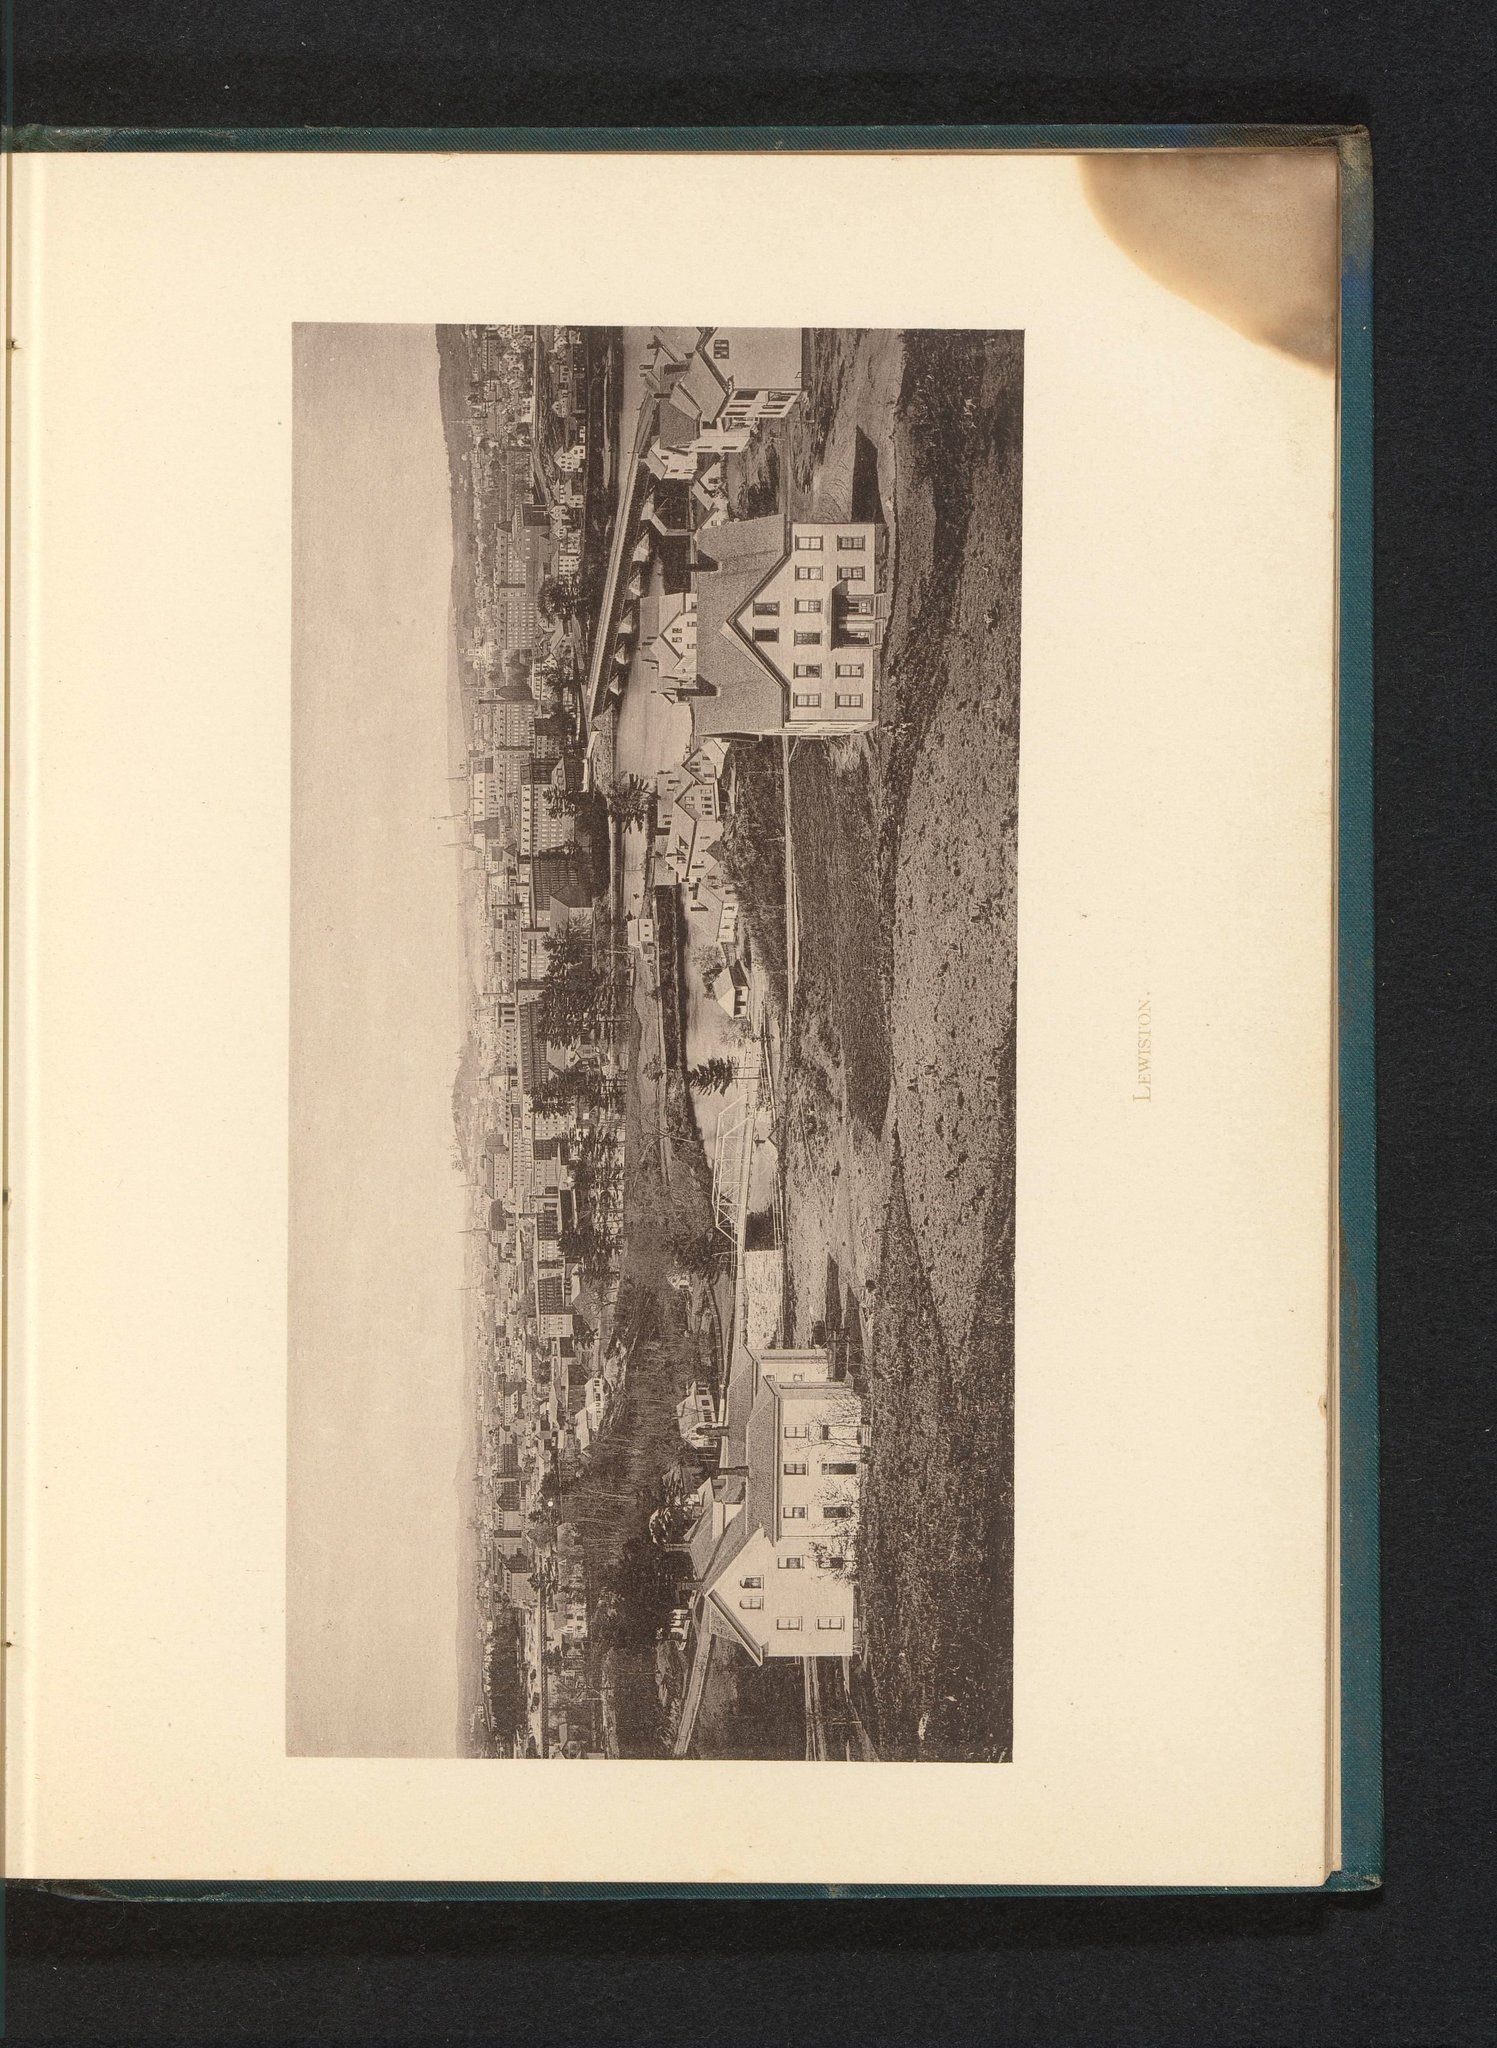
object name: photomechanical print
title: Gezicht op Lewiston, Maine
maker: Anonymous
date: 1875-1880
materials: paper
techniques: photograph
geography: lewiston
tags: city-view, and landscape with man-made constructions